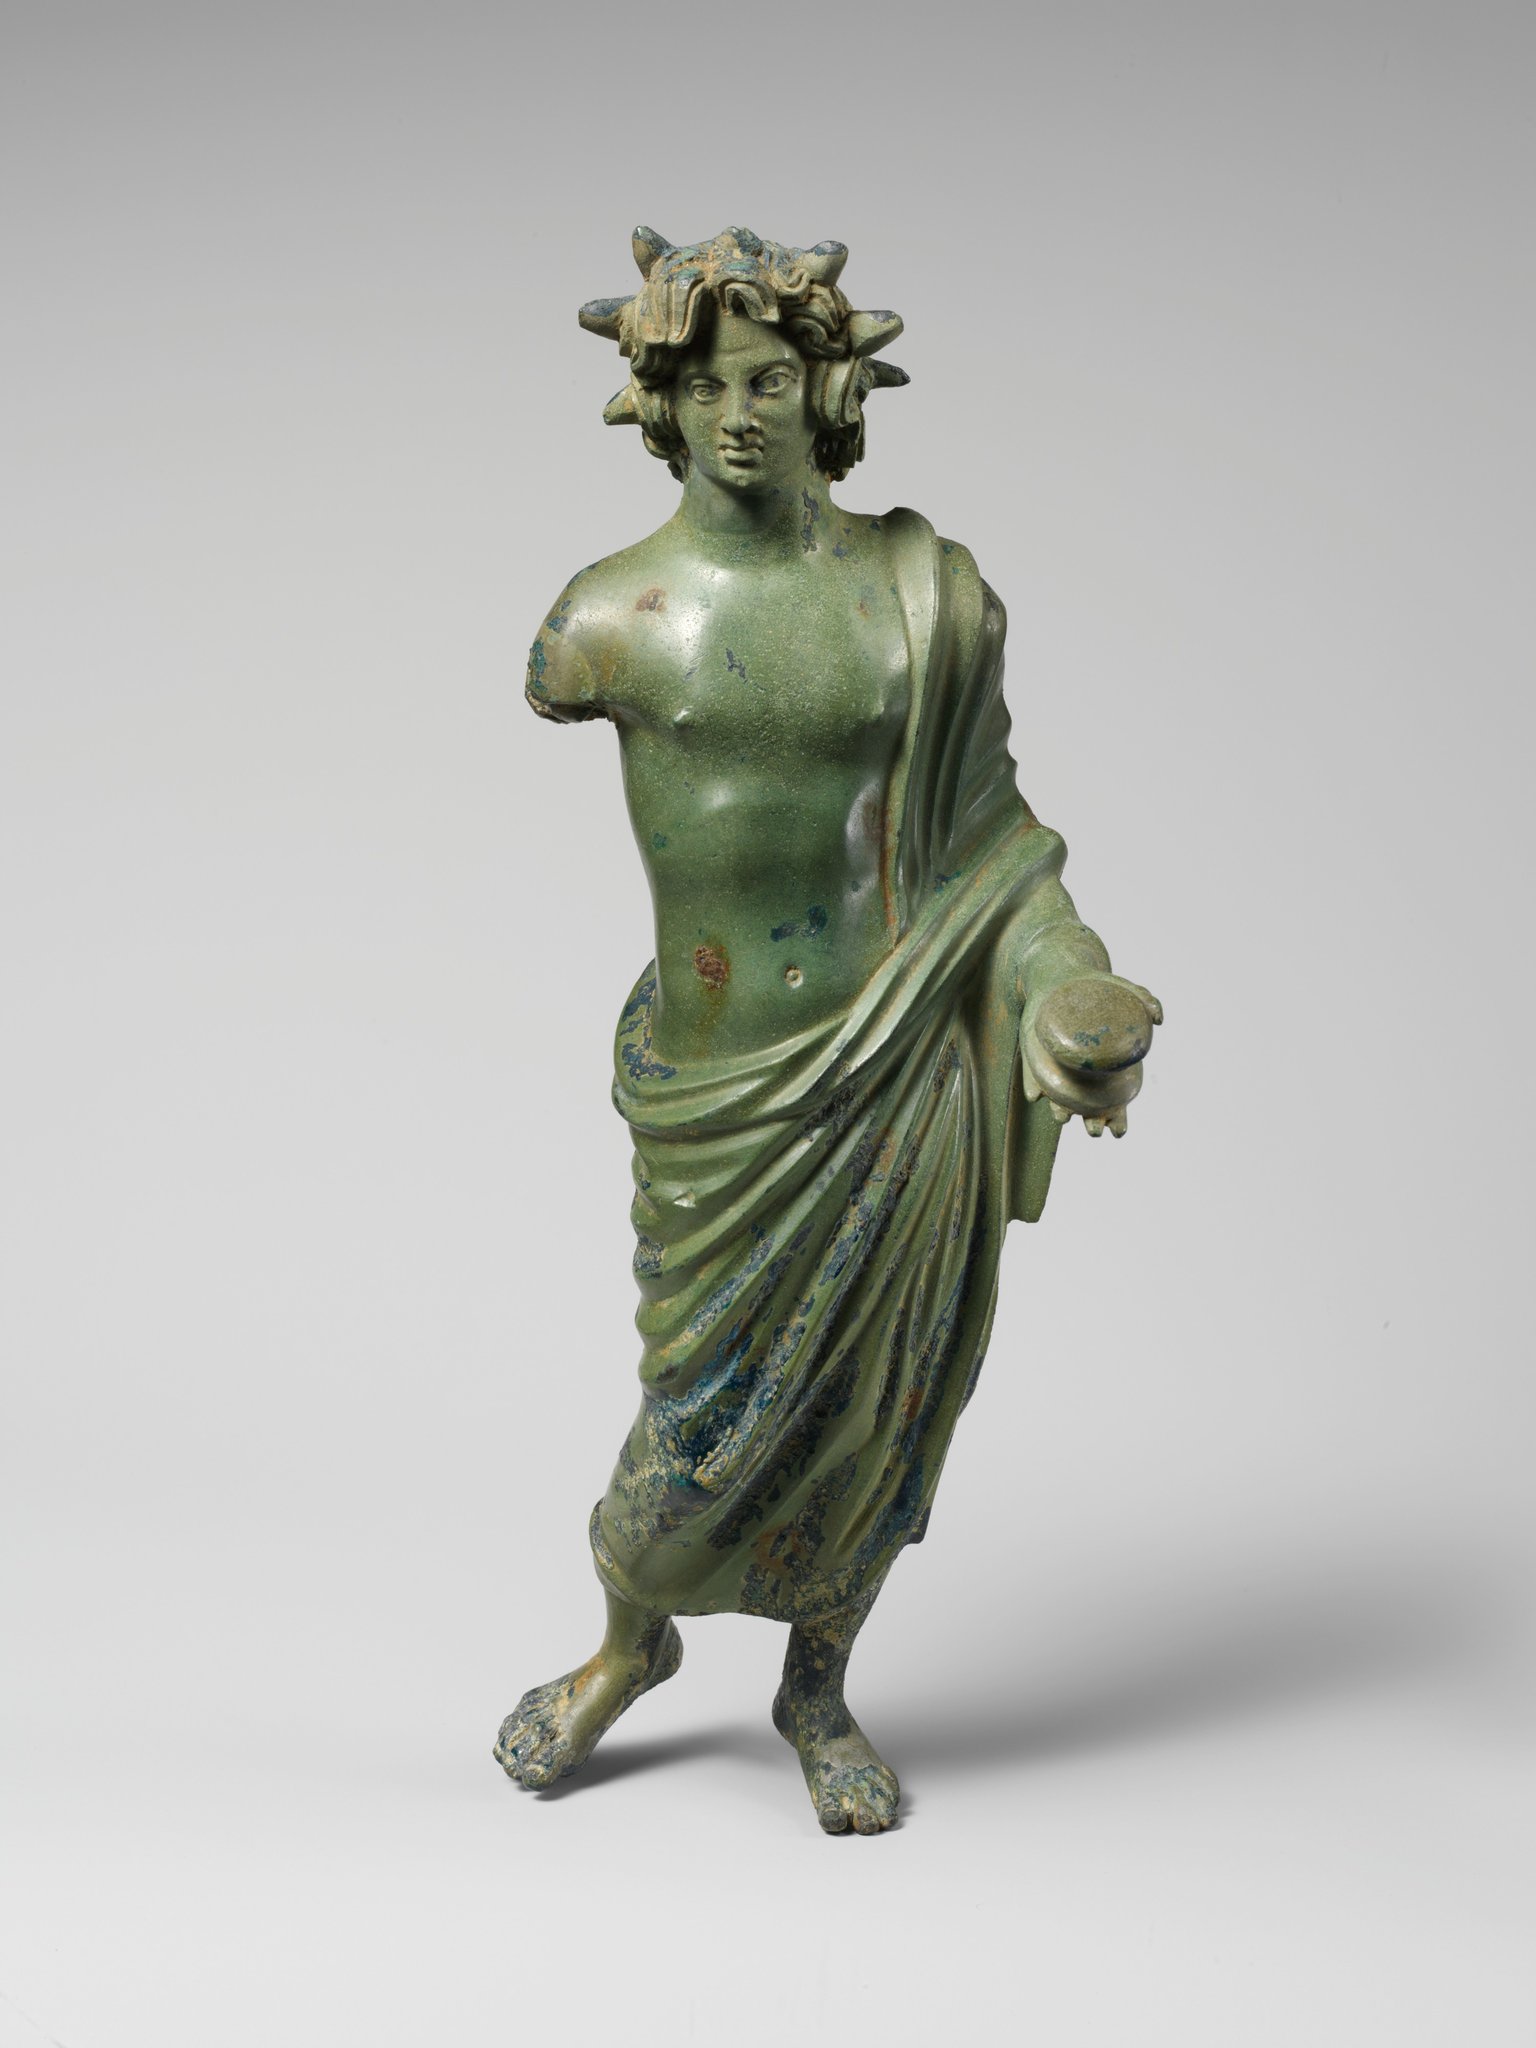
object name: statuette of a priest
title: Bronze statuette of a solar deity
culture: etruscan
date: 300-101 BCE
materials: bronze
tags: apollo